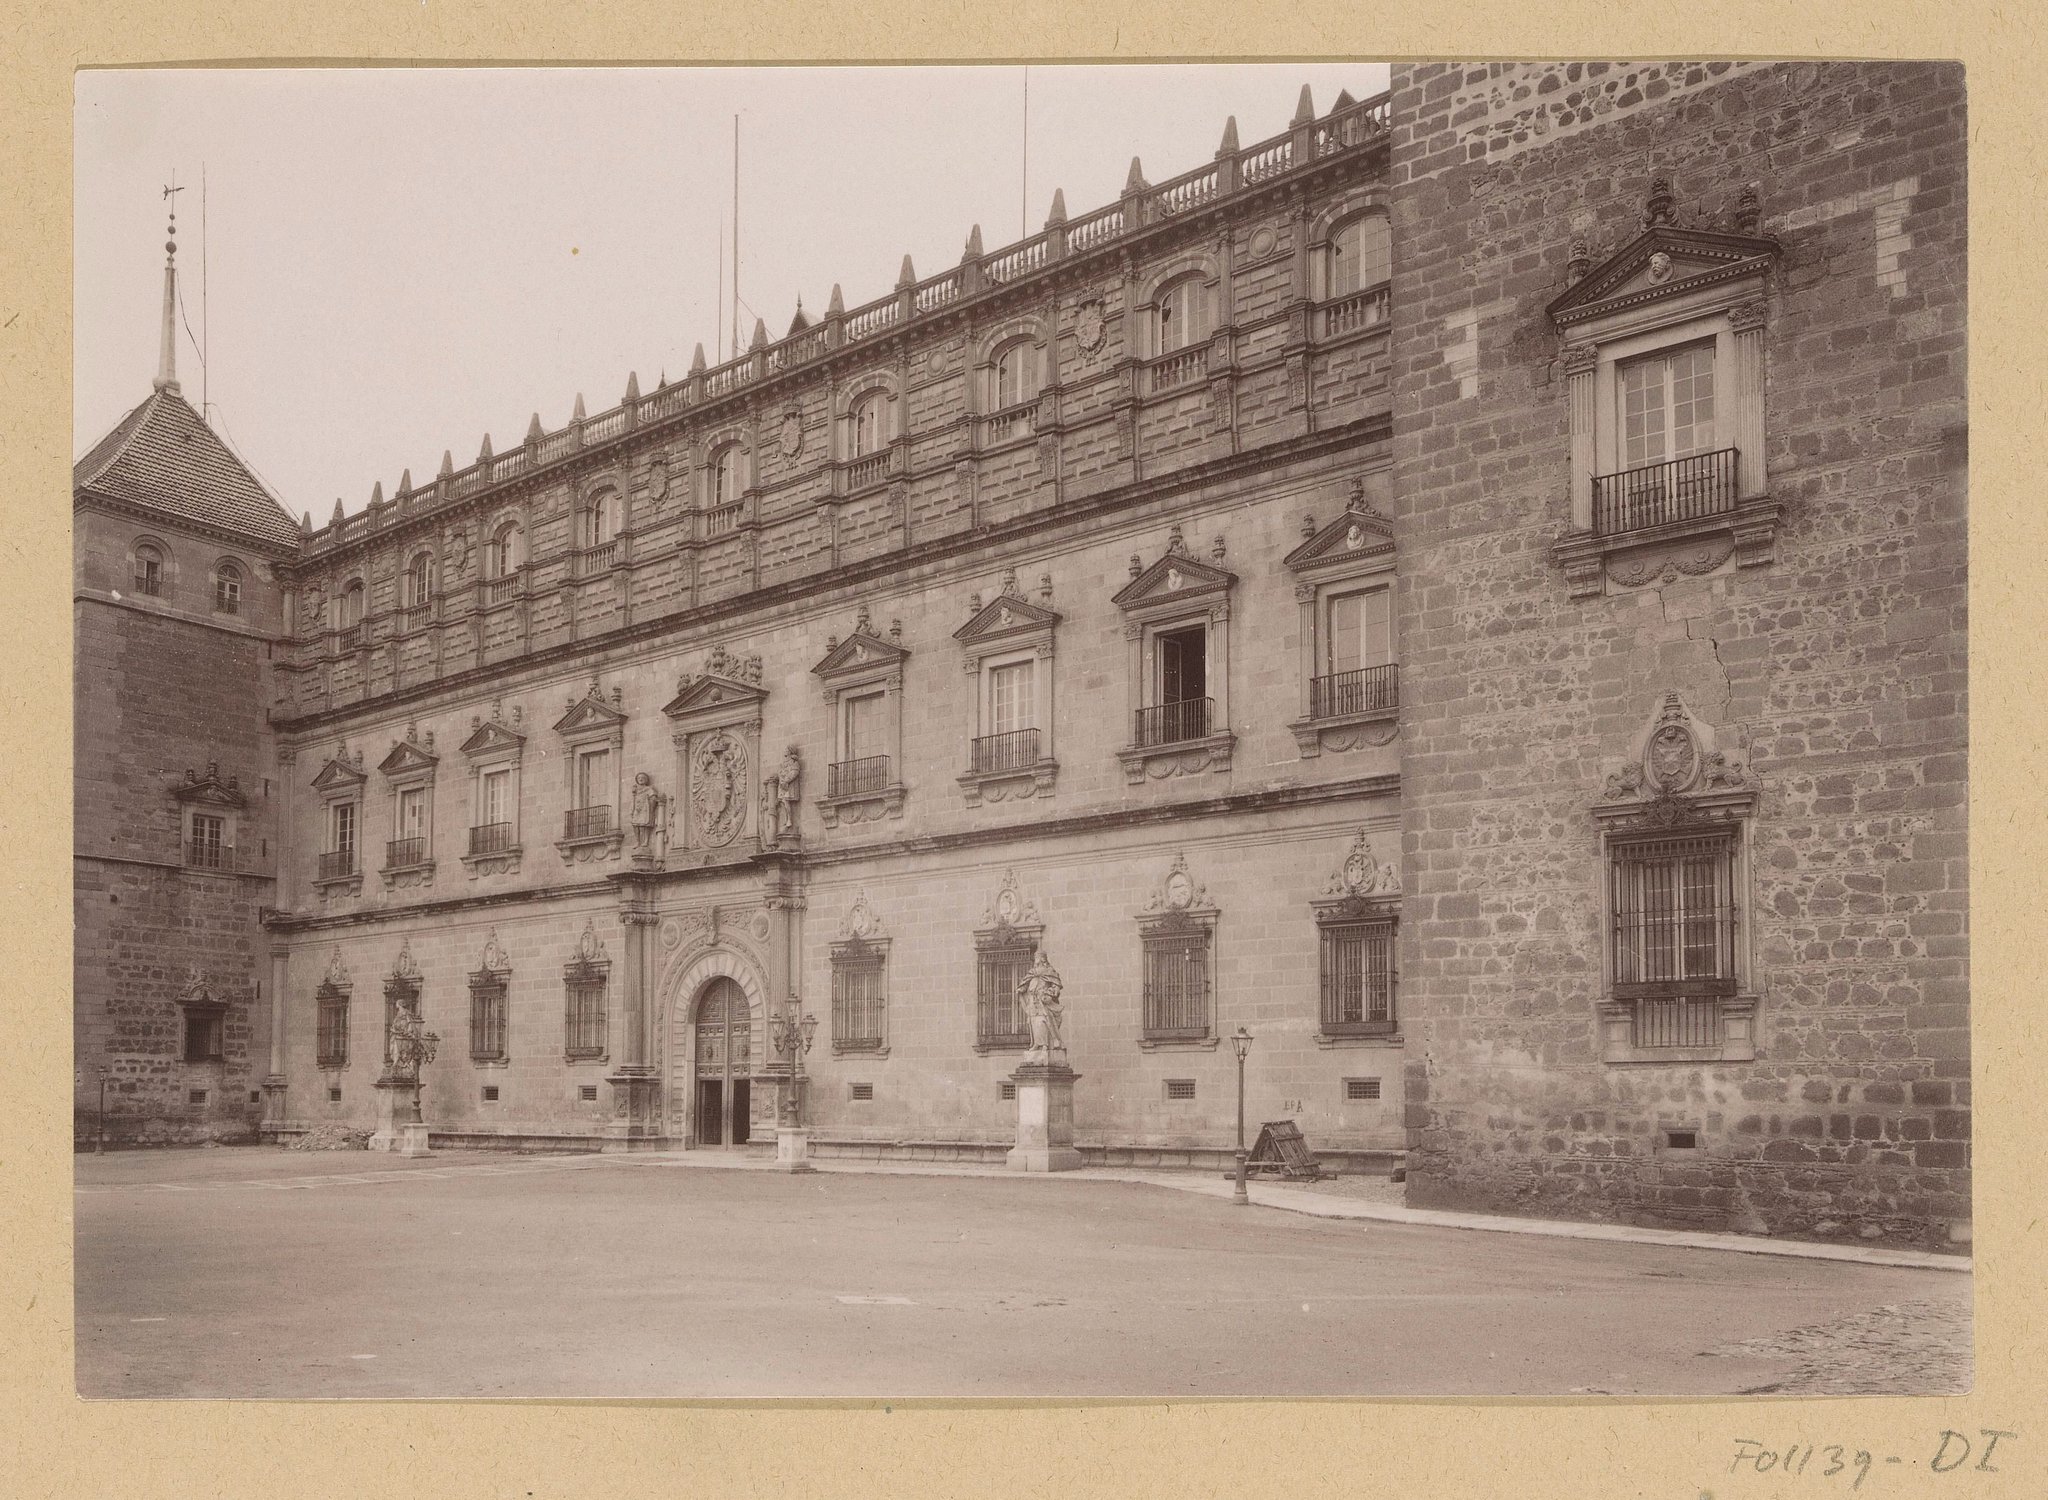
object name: photograph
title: Façade van het Alcázar van Toledo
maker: Anonymous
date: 1851-1890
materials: paper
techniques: albumen print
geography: toledo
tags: fortress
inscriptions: inscription: ‘Toledo’